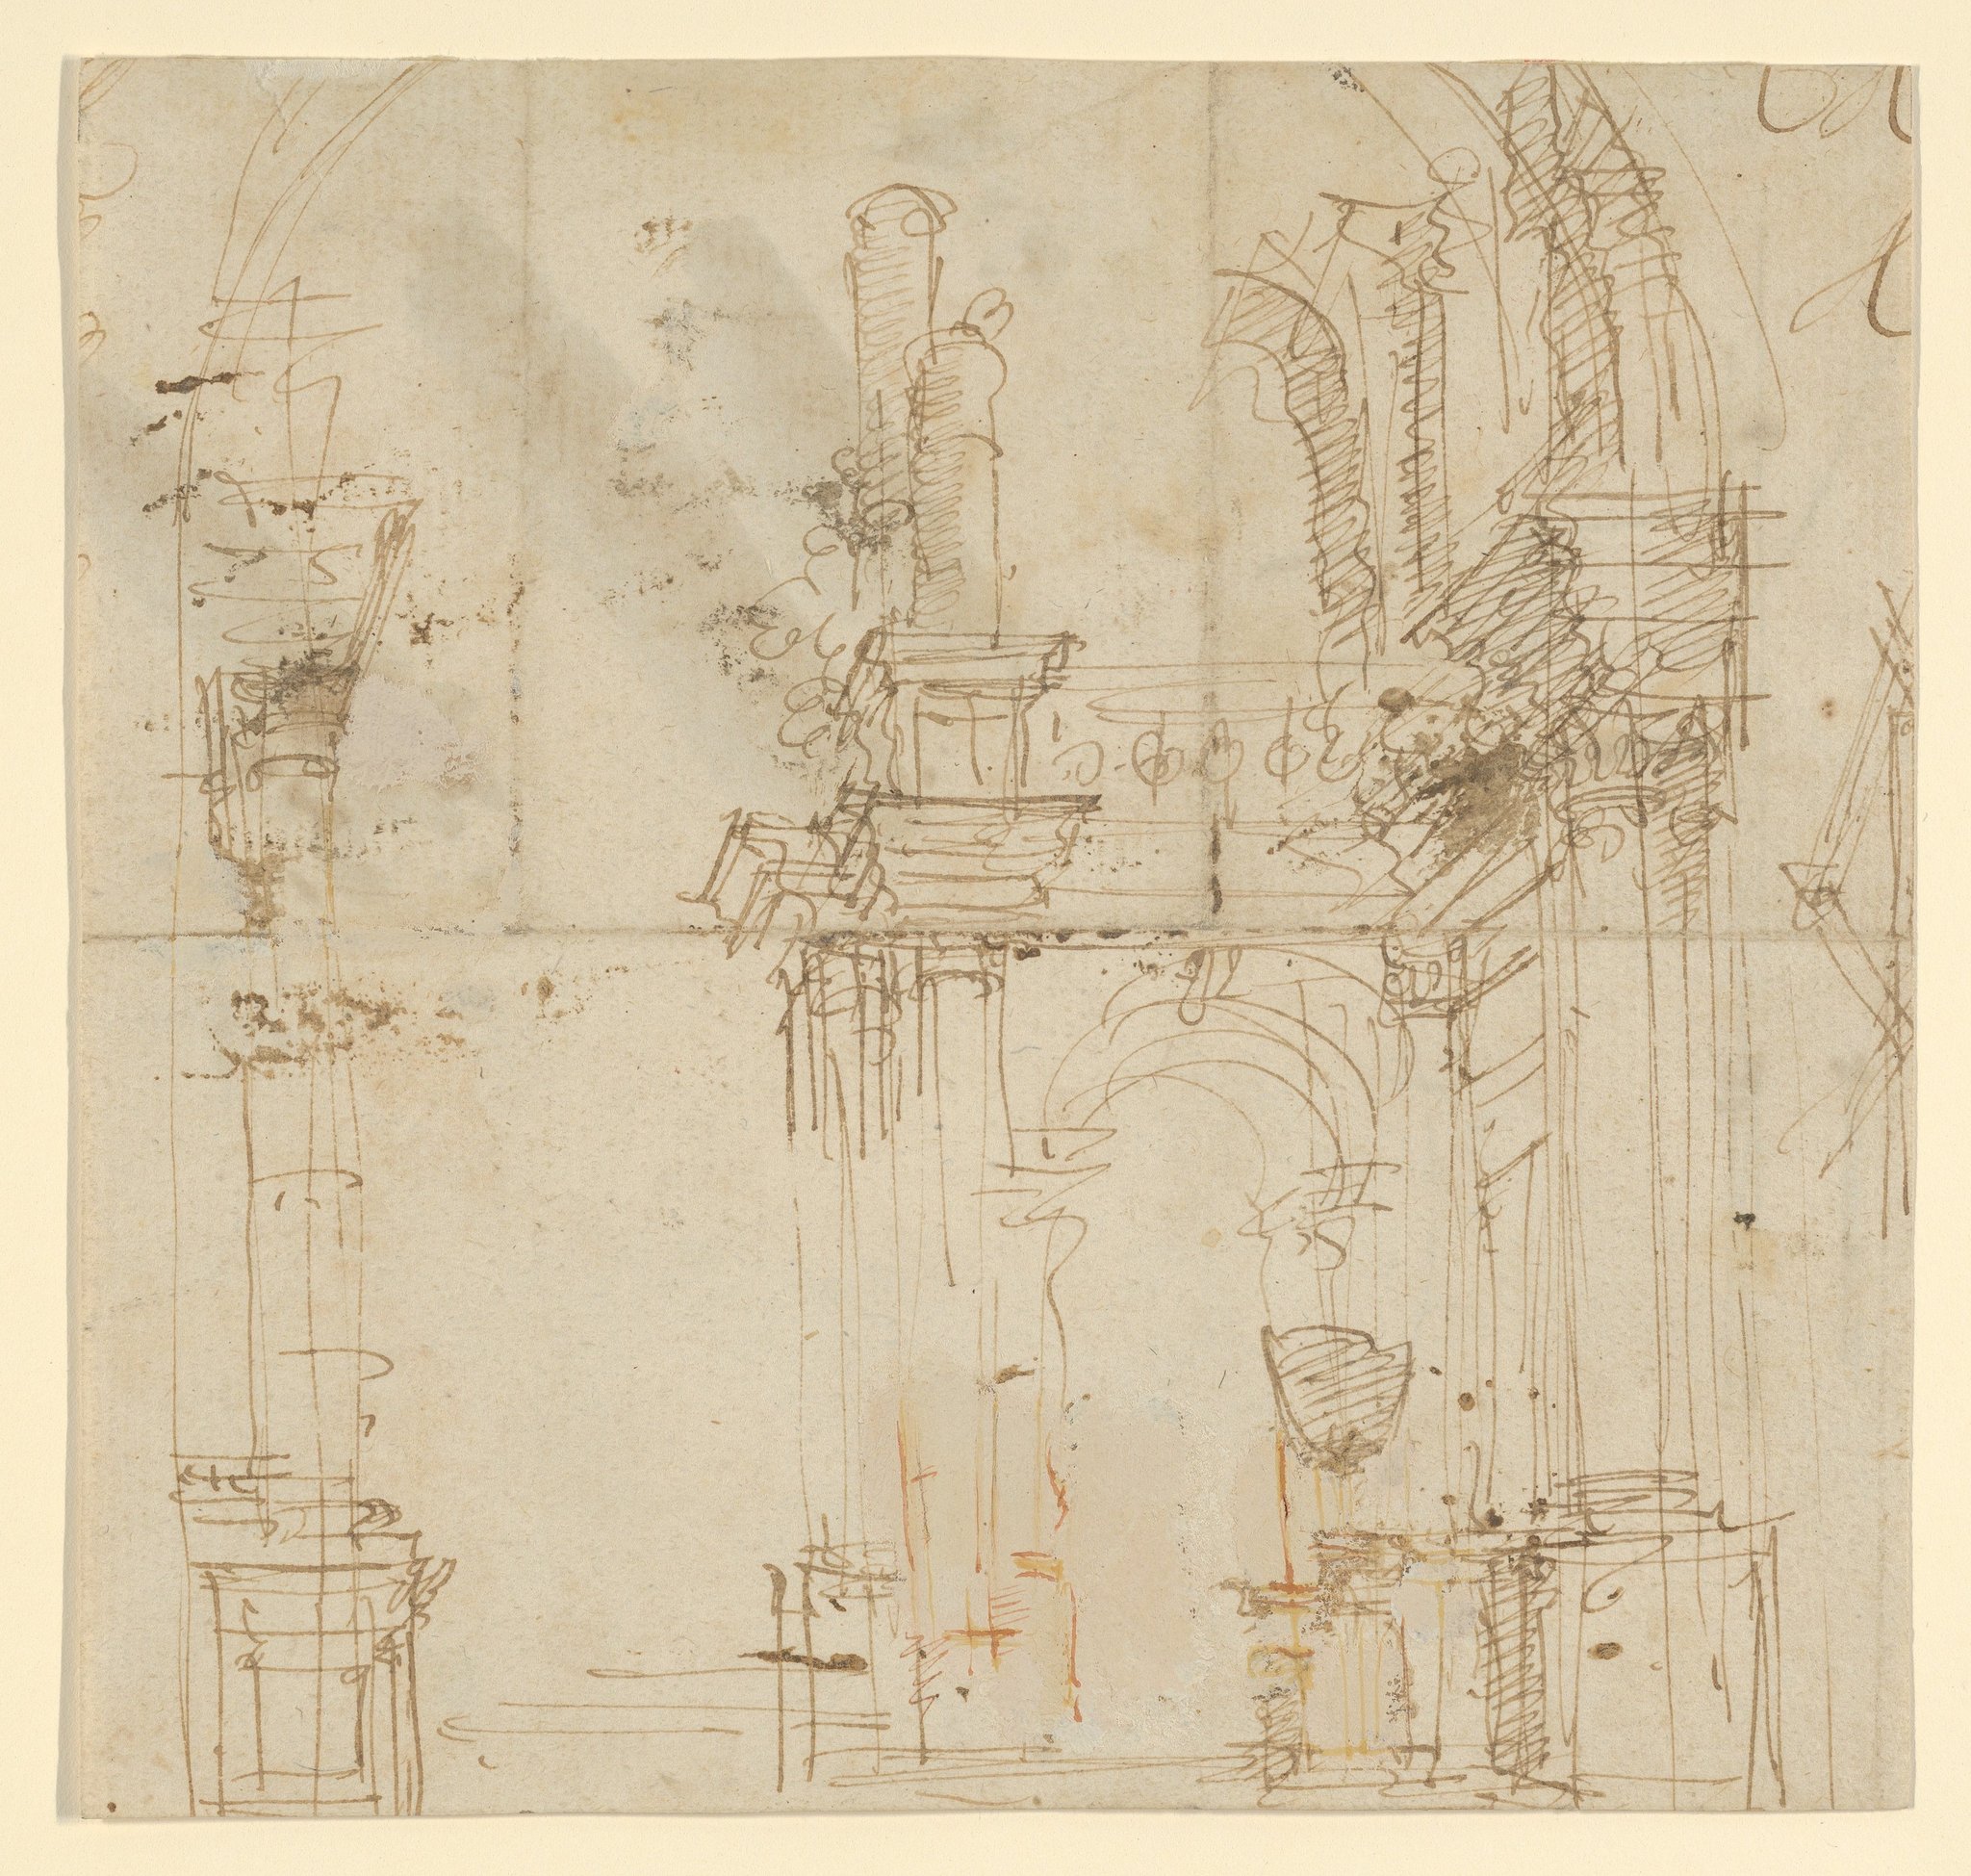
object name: drawing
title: Architectural drawing of arches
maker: anonymous, italian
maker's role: artist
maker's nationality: italian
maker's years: 1400-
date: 1700-1750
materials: ink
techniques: pen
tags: architecture,arches